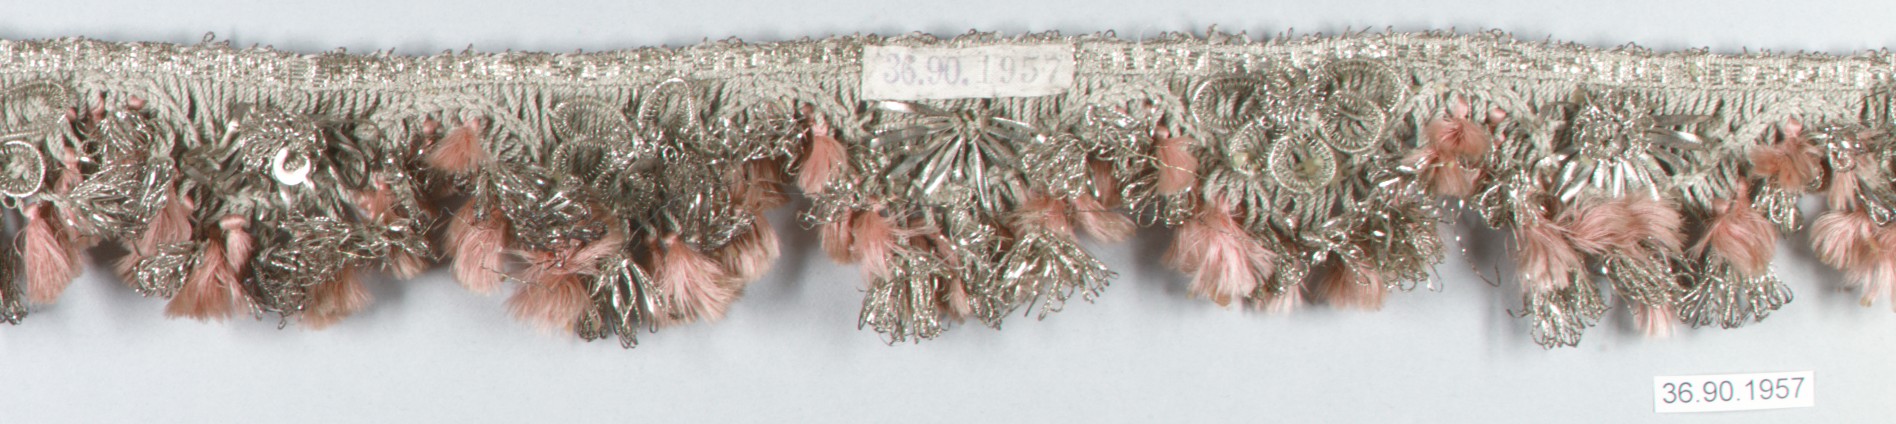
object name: fringe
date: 1601-1700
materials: metal thread